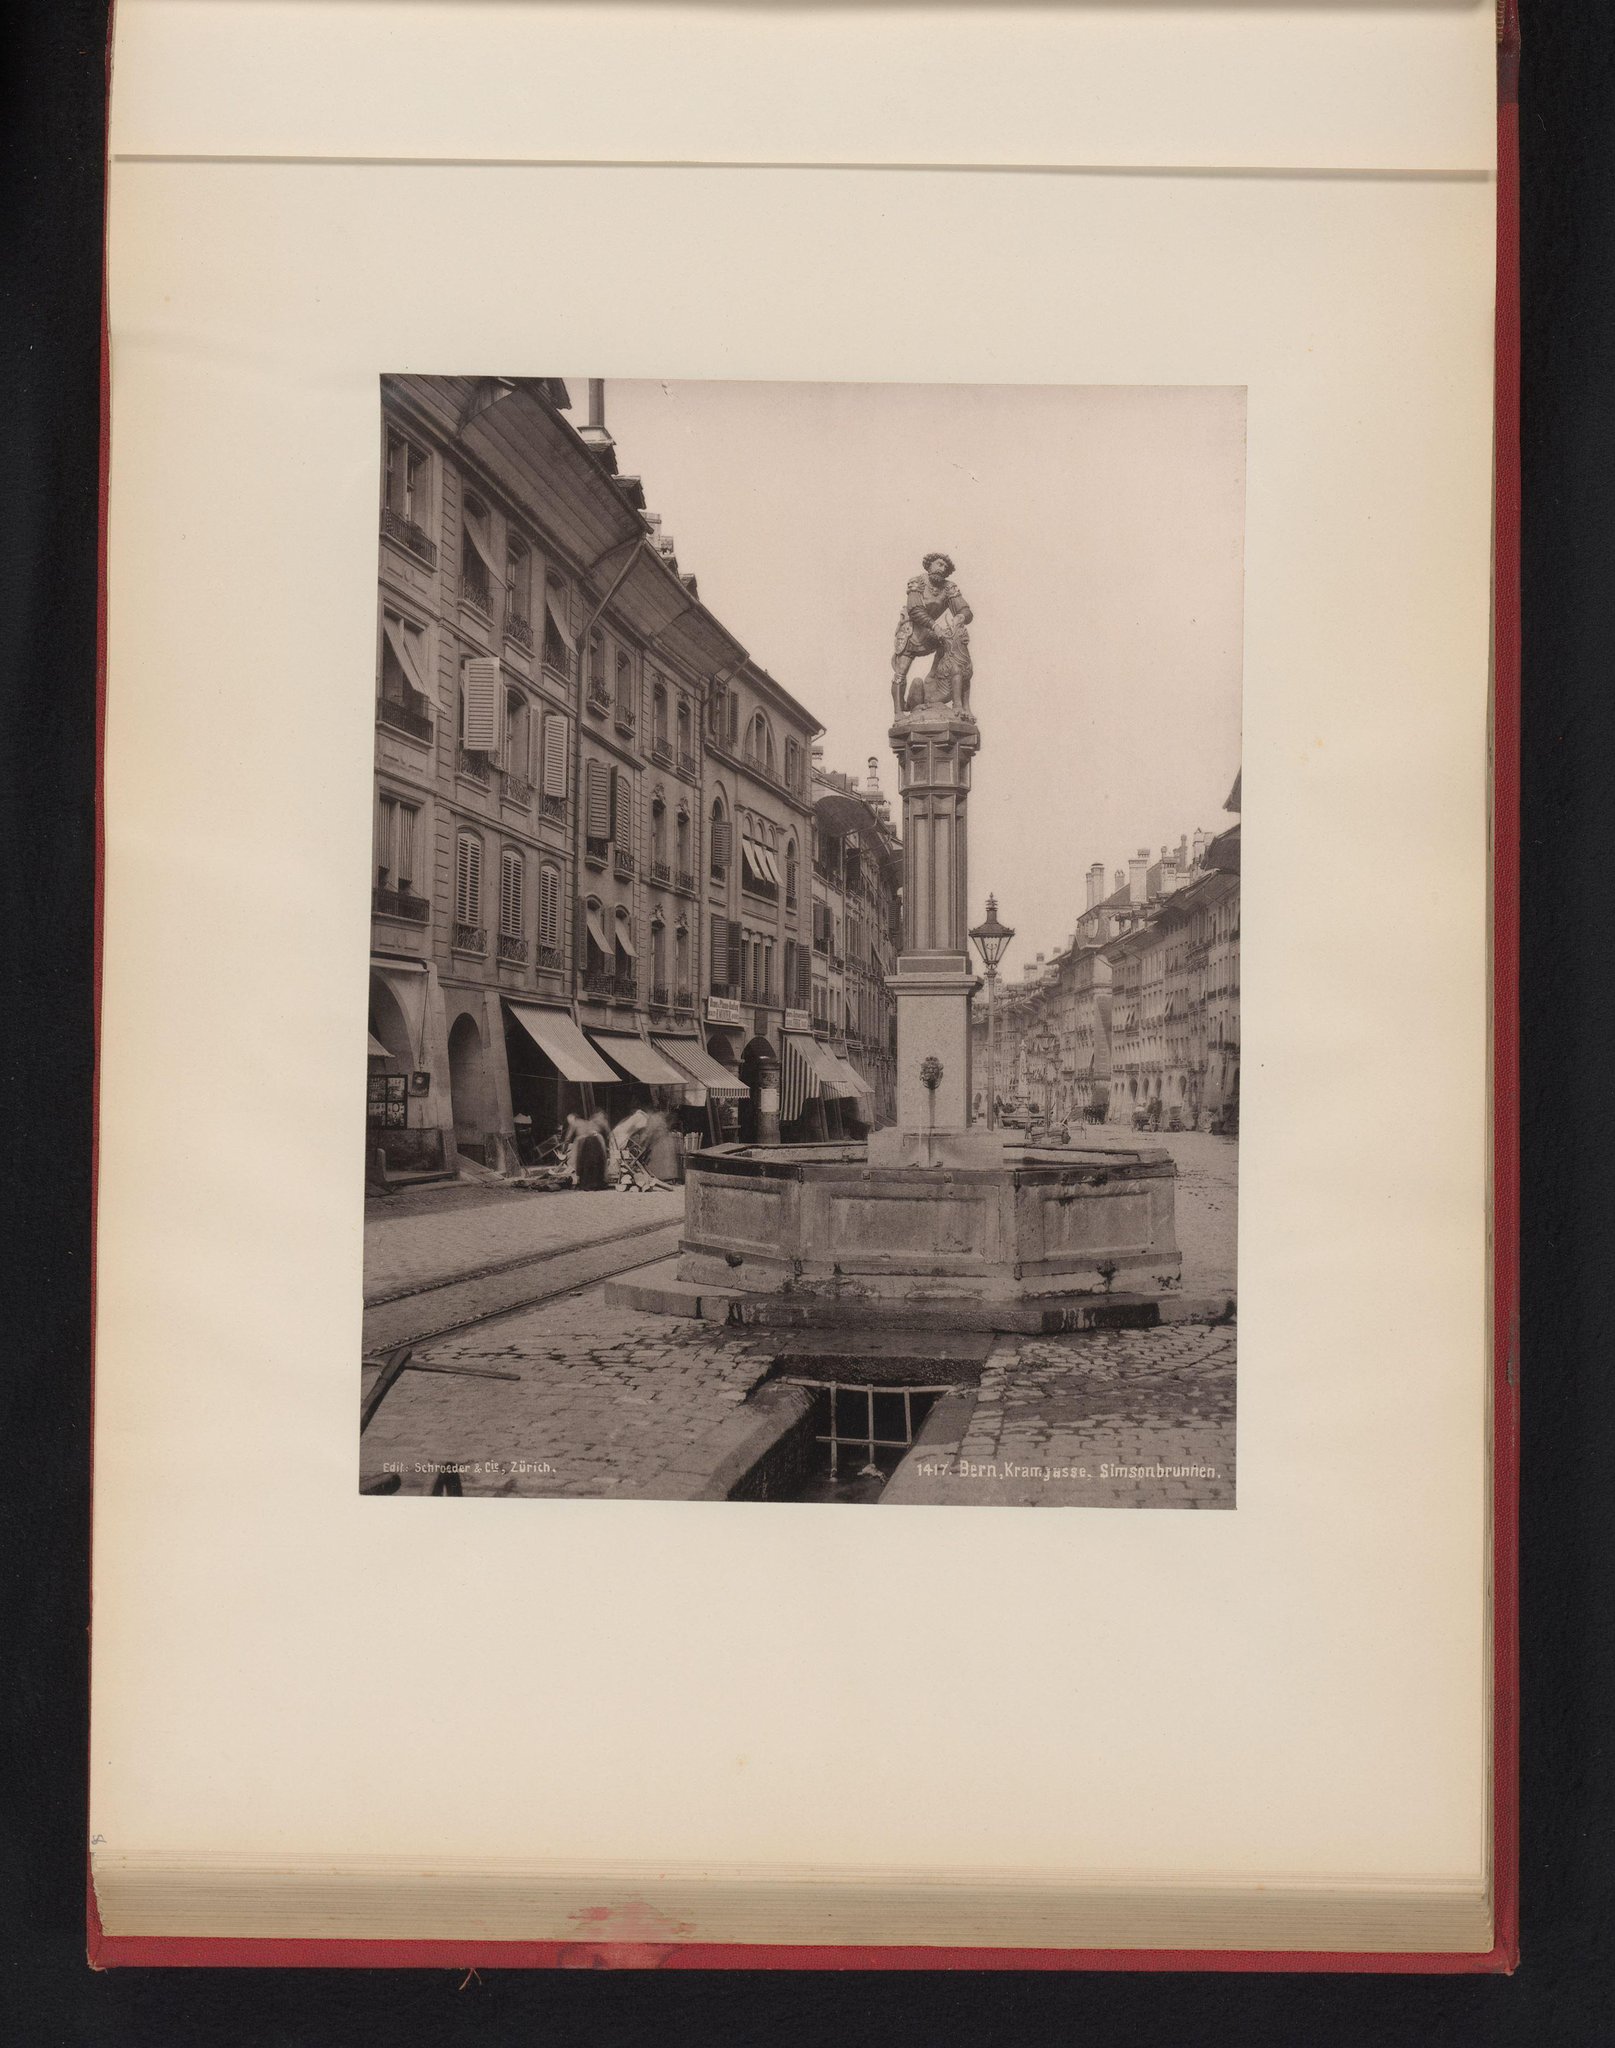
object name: photomechanical print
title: Straatgezicht van de Kramgasse met de Simsonbrunnen te Bern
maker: Anonymous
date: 1880-1900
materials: paper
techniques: photograph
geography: bern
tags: ornamental fountain, street (+ city(-scape) with figures, staffage)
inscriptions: inscription: ‘Edit: Schroeder & Cie, Zürich. 1417. Bern, Kramgasse, Simsonbrunnen.’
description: Deze prent maakt deel uit van een album.